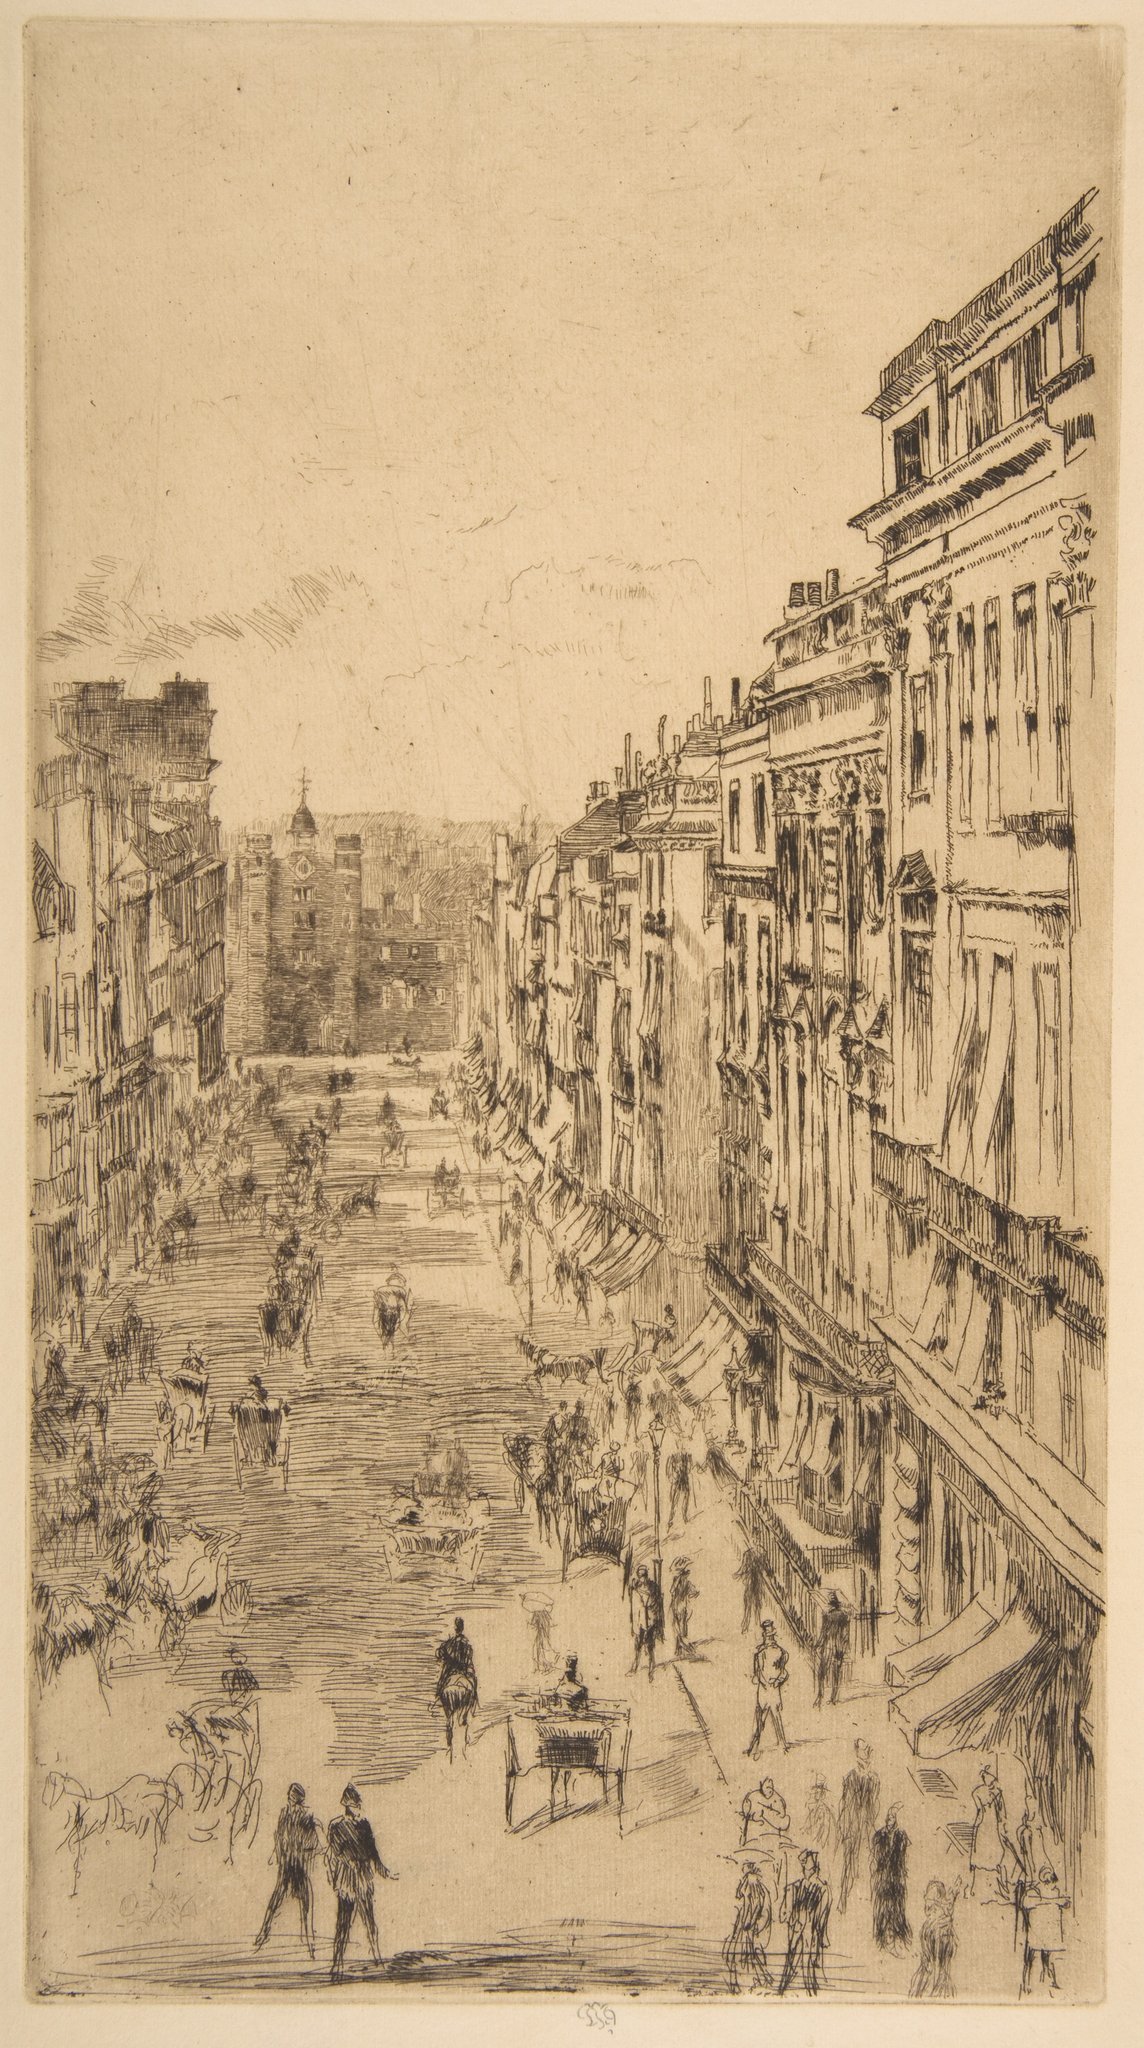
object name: print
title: St. James's Street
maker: james mcneill whistler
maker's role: artist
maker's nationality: american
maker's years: 1834-1903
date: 1878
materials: ink, paper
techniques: drypoint, etching, printing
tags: buildings,streets,london